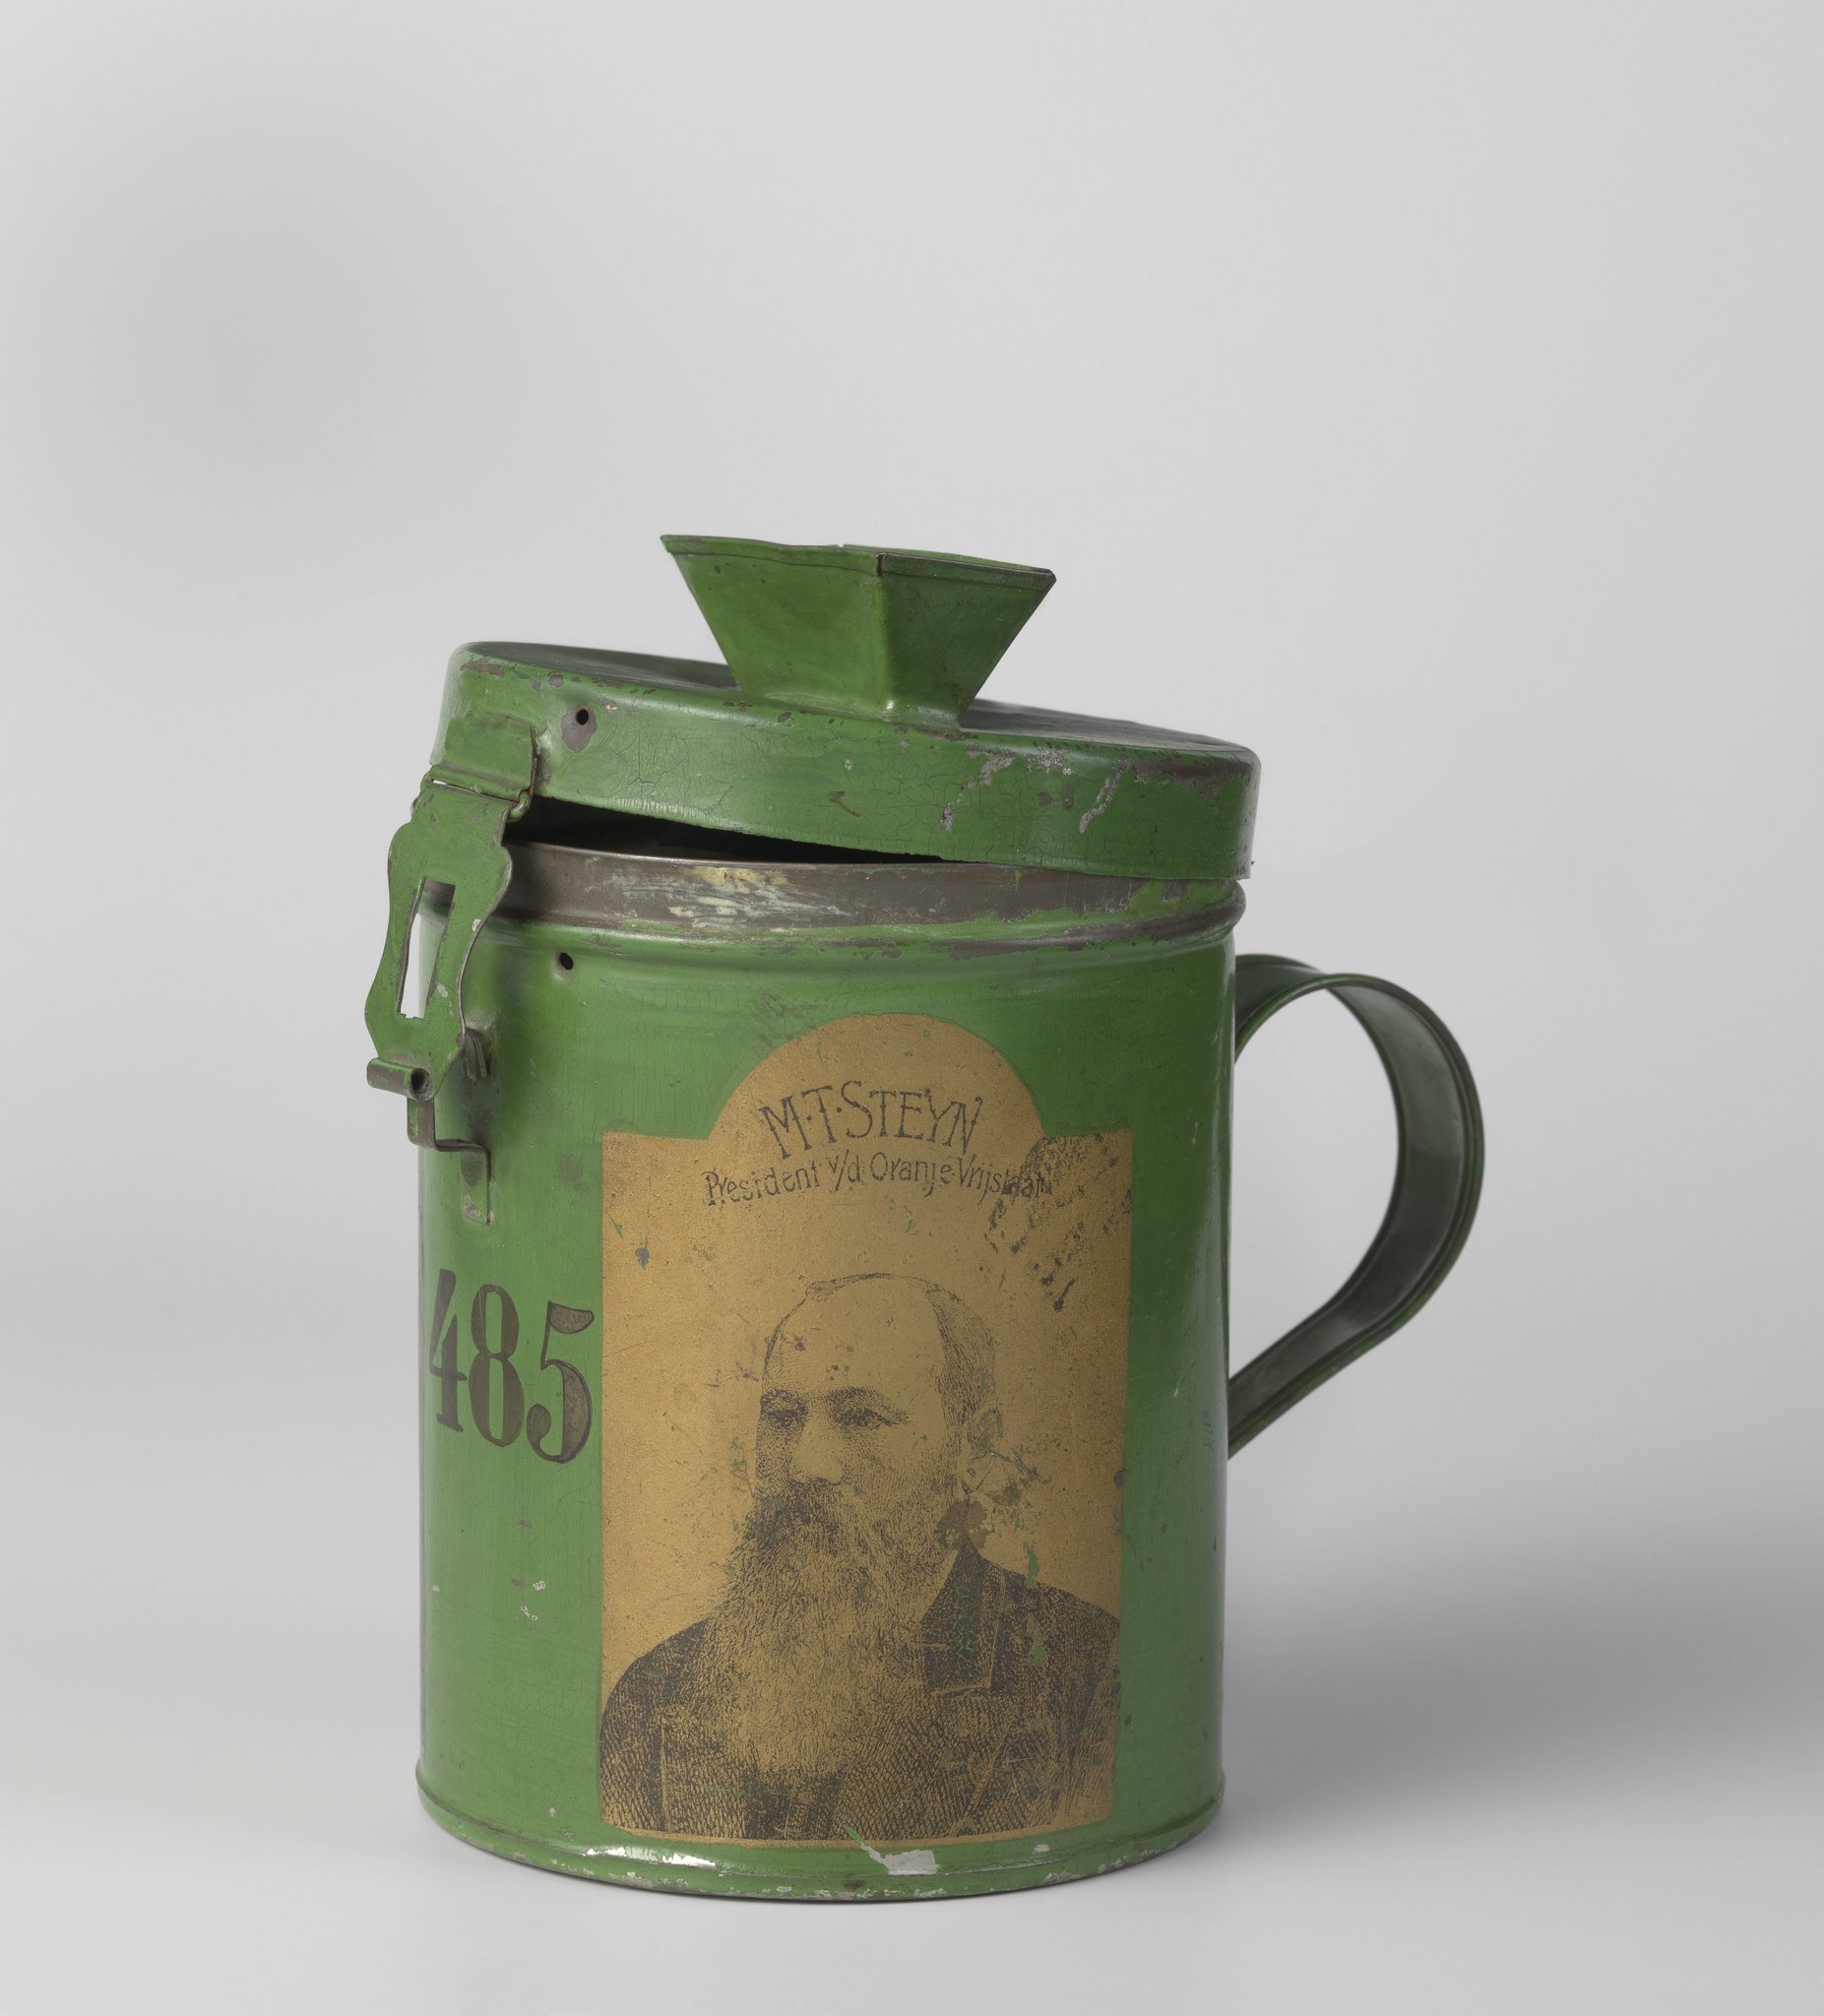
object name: collectebus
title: Collectebus met portretten van Paul Kruger en Marthinus Steyn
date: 1900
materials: metal, paper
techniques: lacquer, printing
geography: dordrecht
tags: politician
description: Collectebus waarmee in Nederland geld werd opgehaald ter ondersteuning van de Zuid-Afrikaanse Boeren in hun strijd tegen de Britten tijdens de Tweede Boerenoorlog (1899-1902). Op de zijden portretten van Paul Kruger (president van de Transvaal) en Marthinus Steyn (president van Oranje Vrijstaat). In de collectebus zaten een (waardeloos) bankbiljet van 200 miljoen dollar van de Bank van Zimbabwe en twee (verlopen) biljetten van twee rand van de Zuid-Afrikaanse bank.